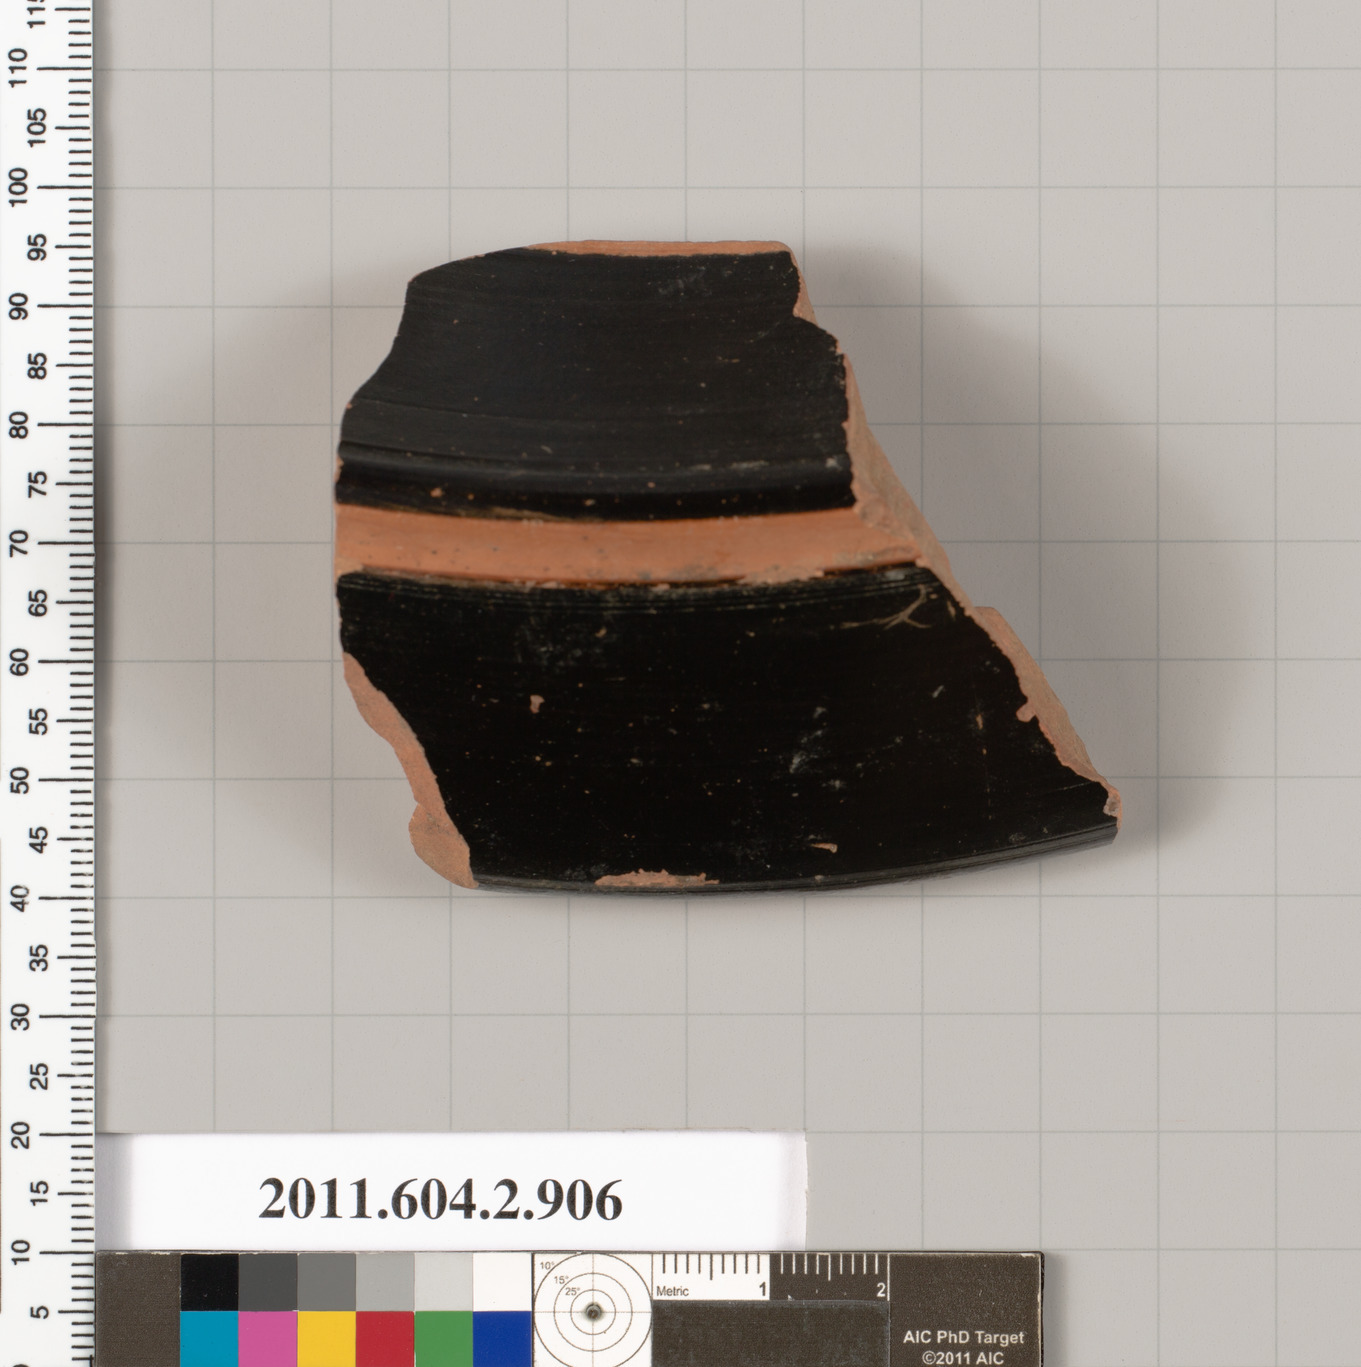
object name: bell krater fragment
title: Terracotta fragment of a bell-krater (bowl for mixing wine and water)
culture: greek, attic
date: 460-440 BCE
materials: terracotta